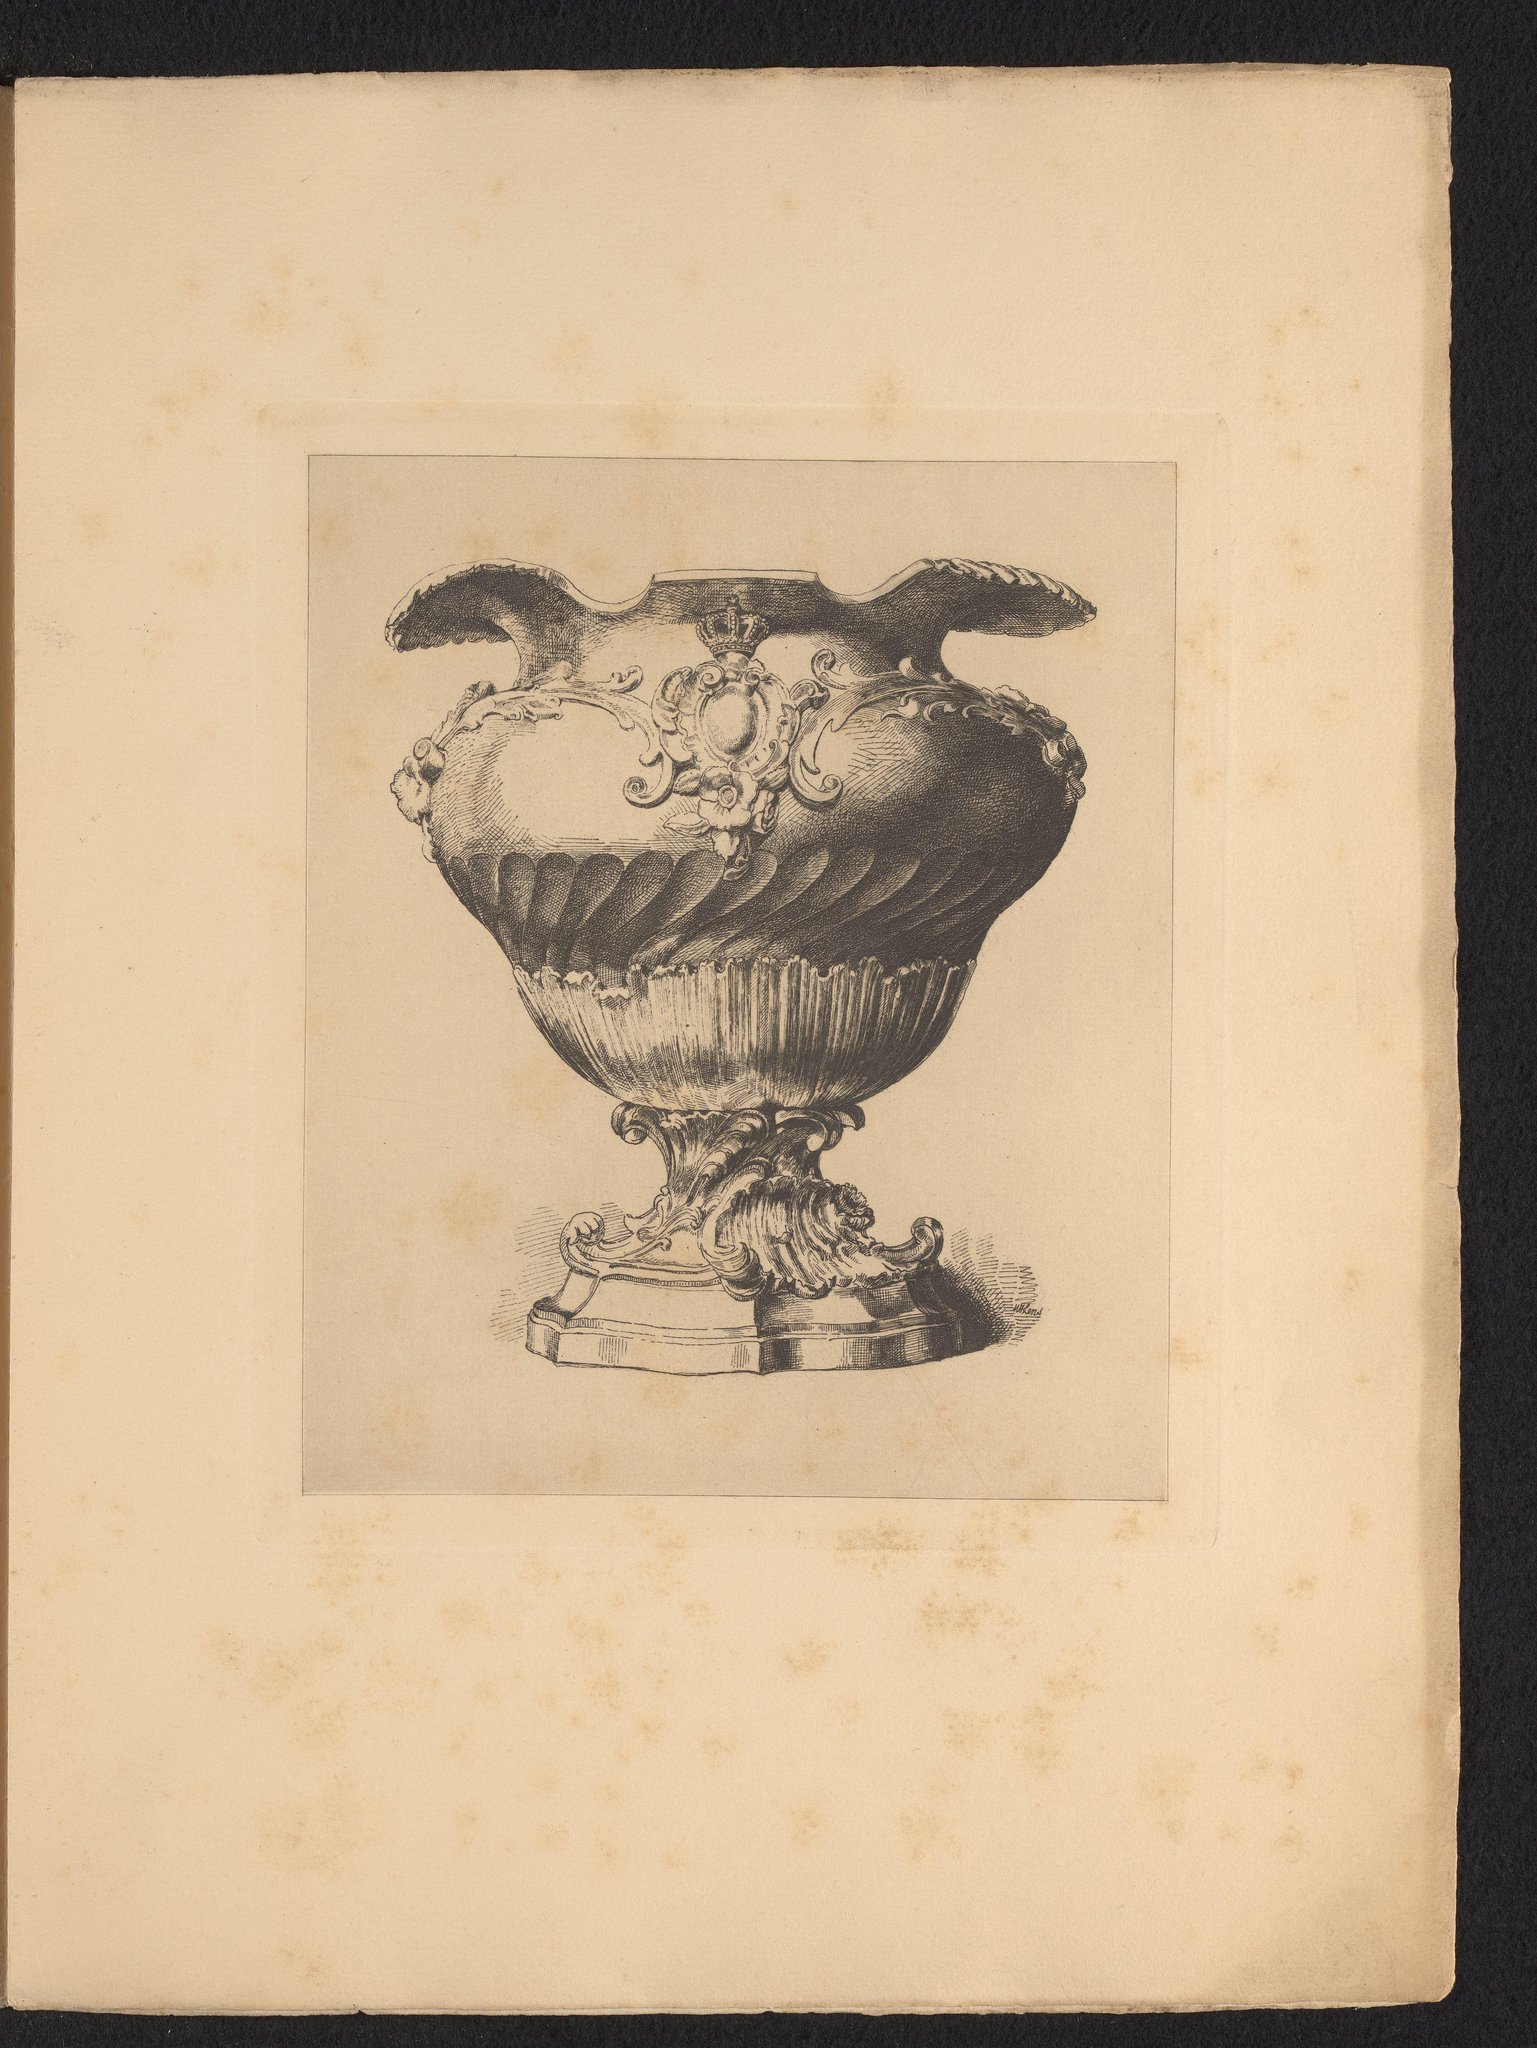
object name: print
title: Vooraanzicht van een grote ovale vaas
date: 1889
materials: paper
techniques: etching, intaglio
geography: utrecht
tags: vase ~ ornament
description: Prent maakt deel uit van een serie van veertien prenten.